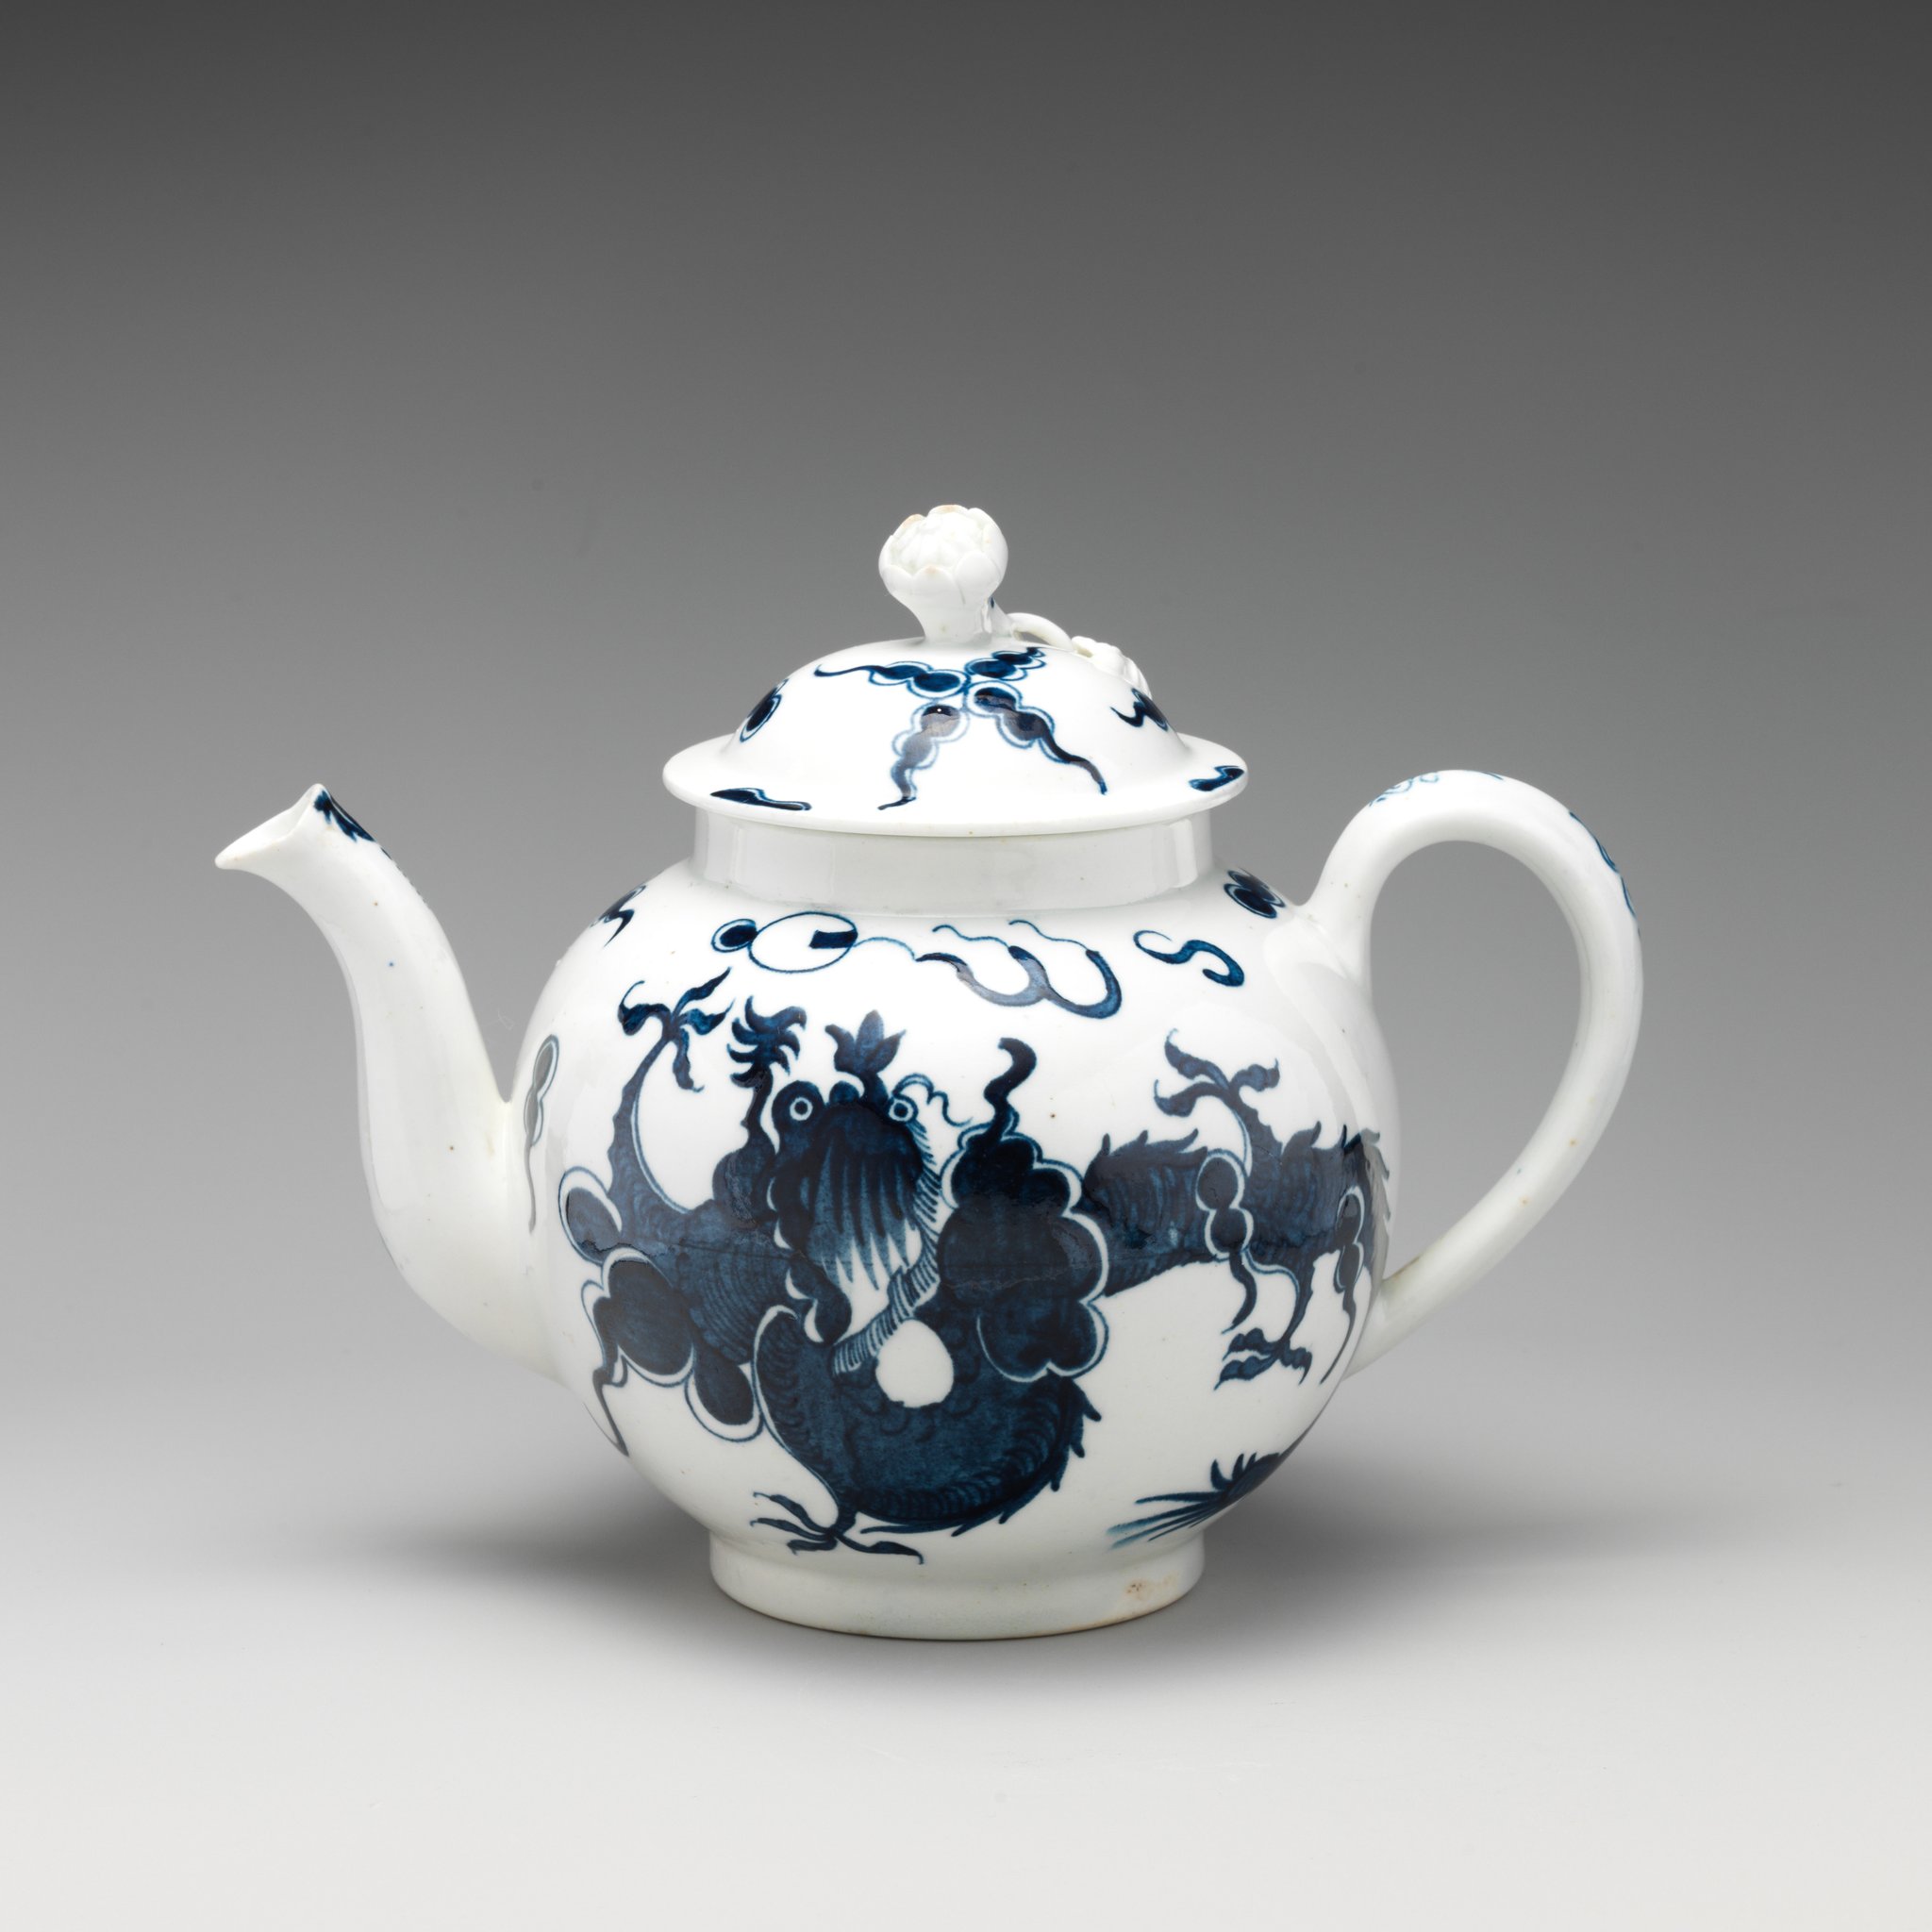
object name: teapot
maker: lowestoft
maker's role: factory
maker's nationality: british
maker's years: 1757-1803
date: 1770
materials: soft paste porcelain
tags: dragons